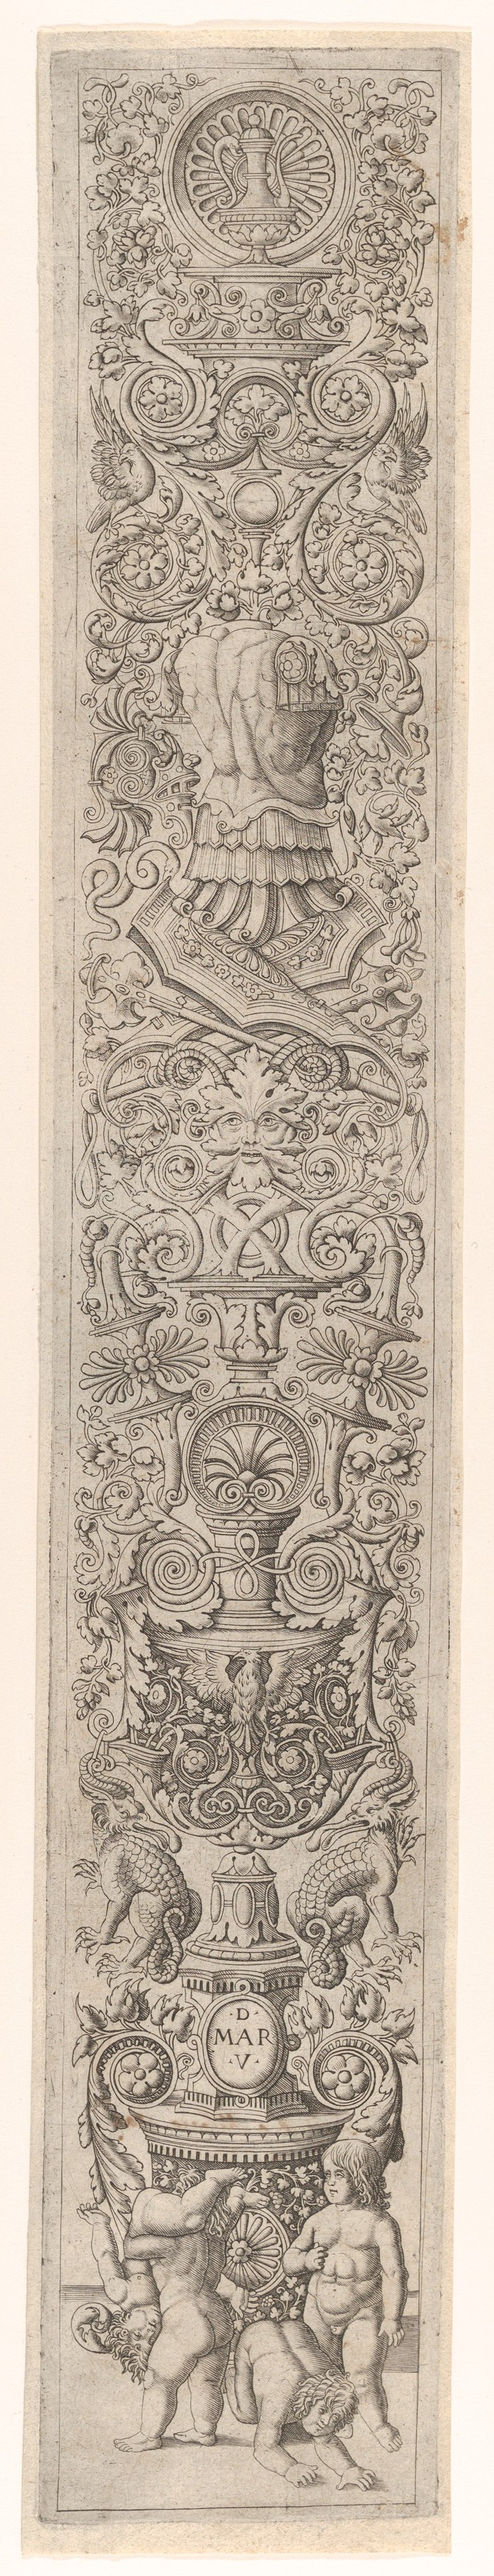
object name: print ornament architecture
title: Candelabra grotesque with four children playing, from a series of twelve candelabra grotesques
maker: giovanni antonio da brescia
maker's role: artist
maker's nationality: italian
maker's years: 1490-1525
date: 1490-1515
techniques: engraving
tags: children,candelabra